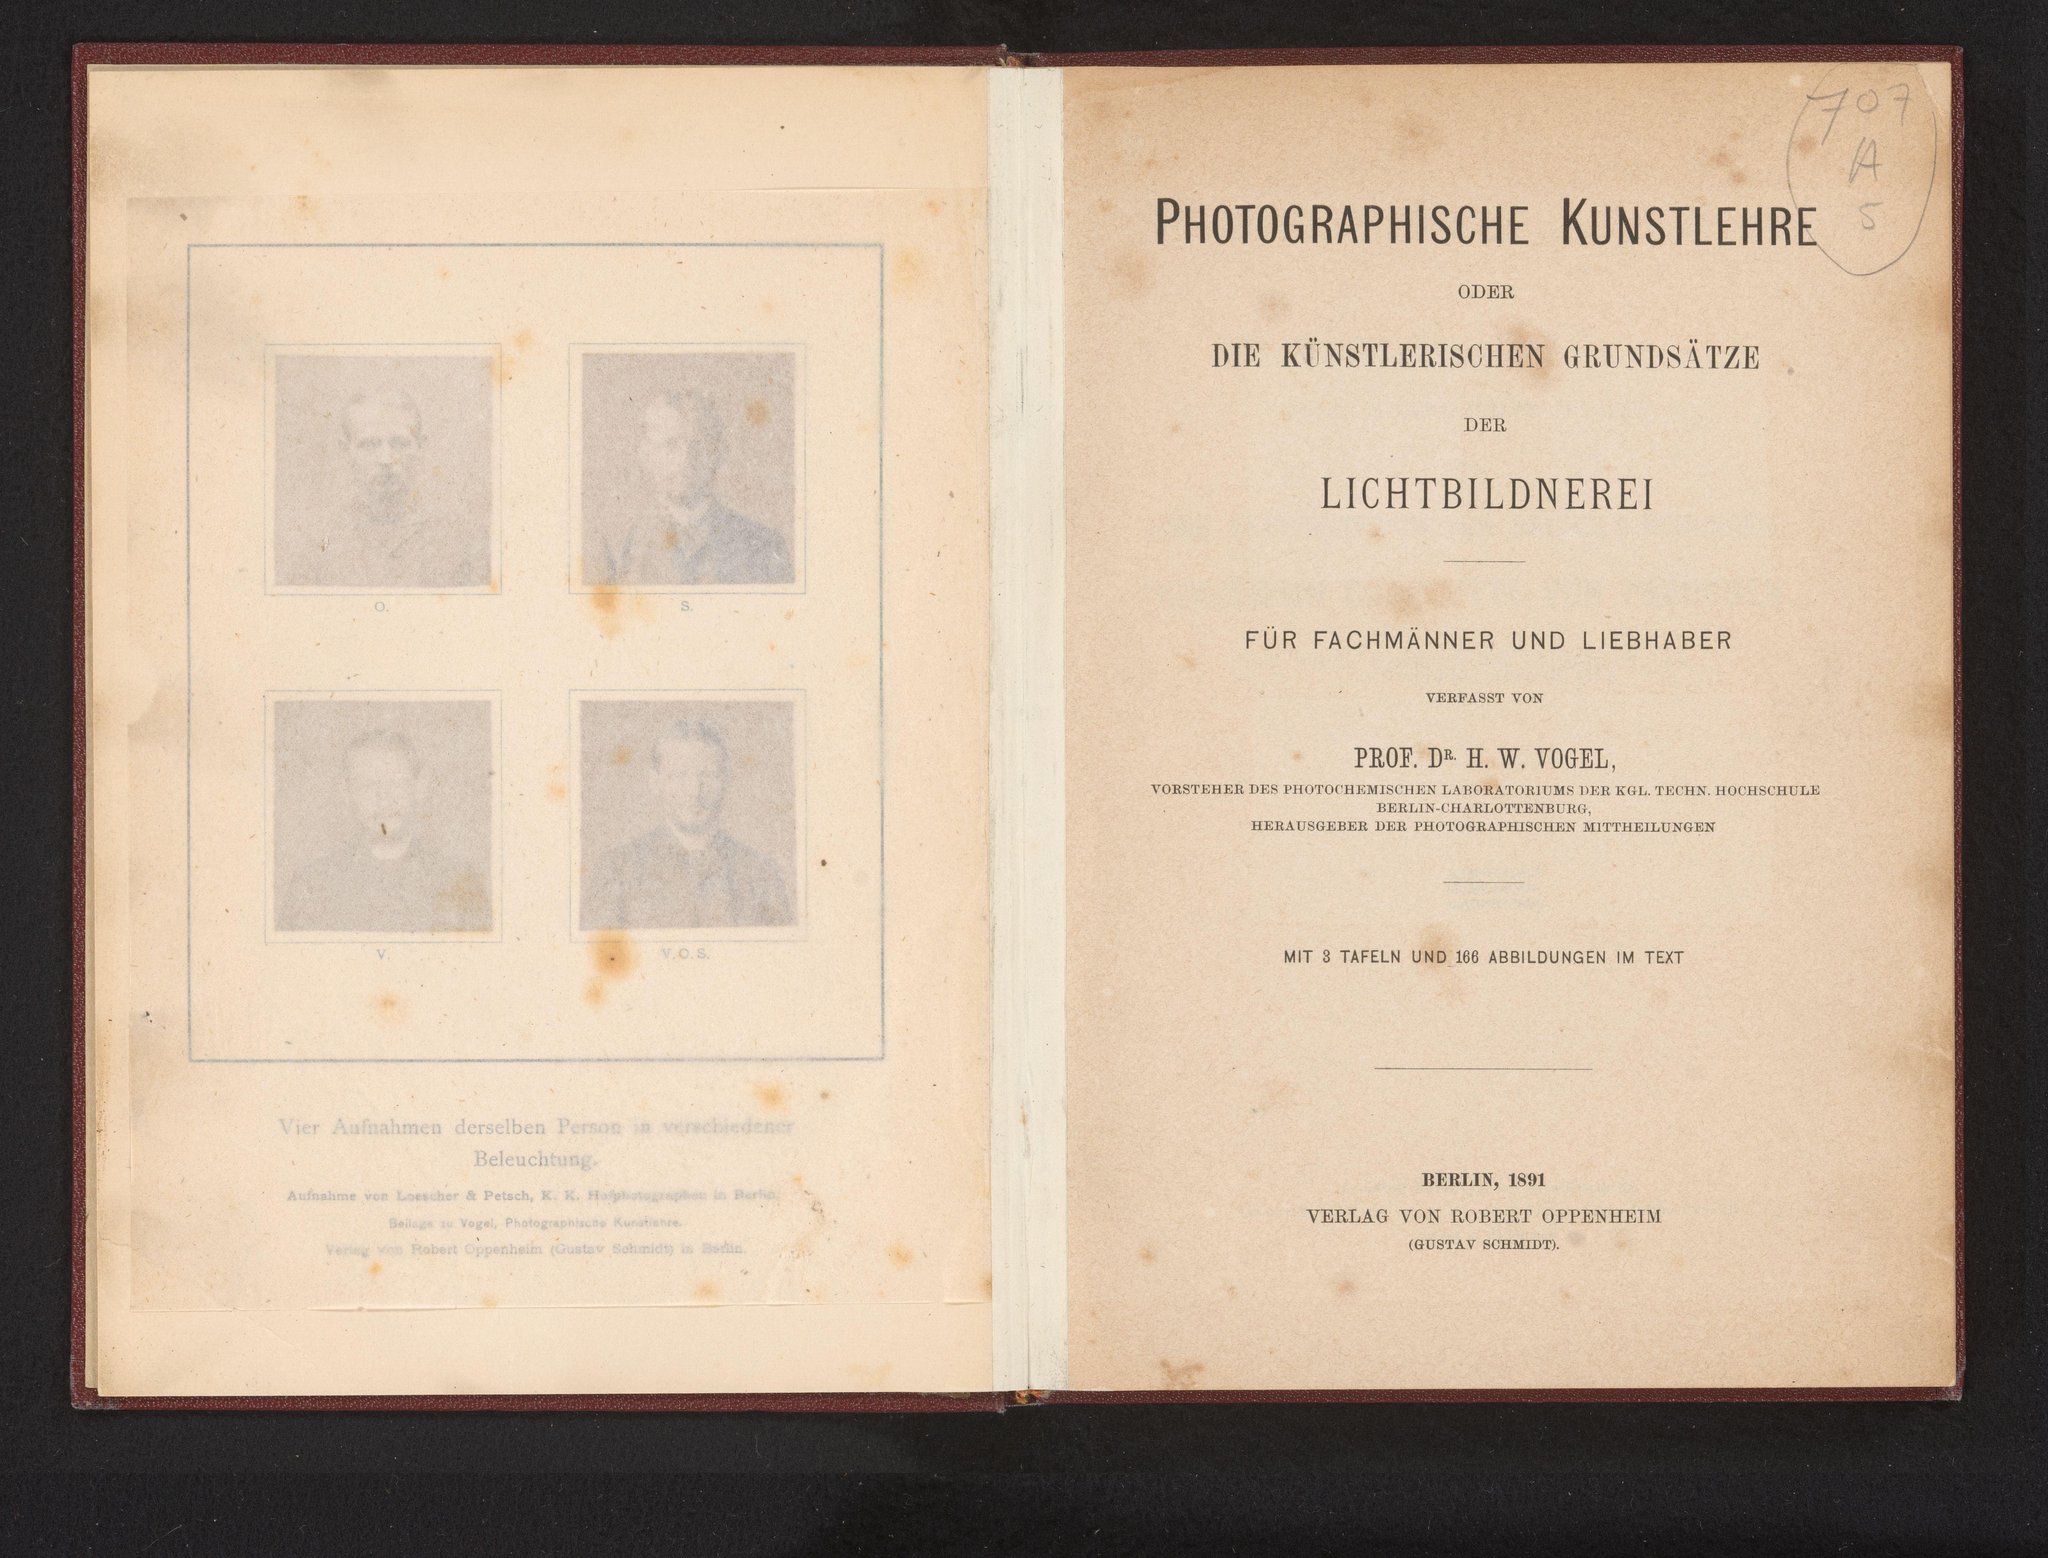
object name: book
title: Photographische Kunstlehre, oder Die künstlerischen Grundsätze der Lichtbildnerei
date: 1891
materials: cardboard, paper, linen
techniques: albumen print, photograph, letterpress printing, photoaquatint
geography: berlin